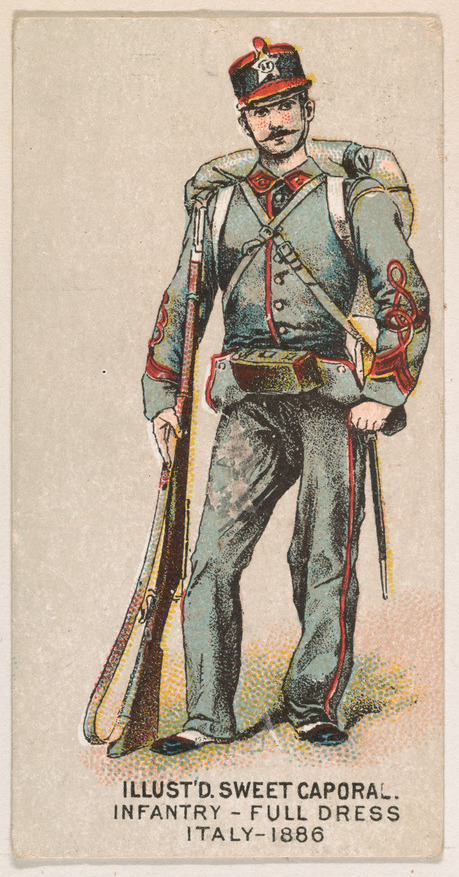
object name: print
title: Full Dress, Infantry, Italy, 1886, from the Military Series (N224) issued by Kinney Tobacco Company to promote Sweet Caporal Cigarettes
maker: kinney brothers tobacco company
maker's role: publisher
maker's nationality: american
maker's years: 1869-2011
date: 1888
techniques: color lithograph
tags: military,firearms,men